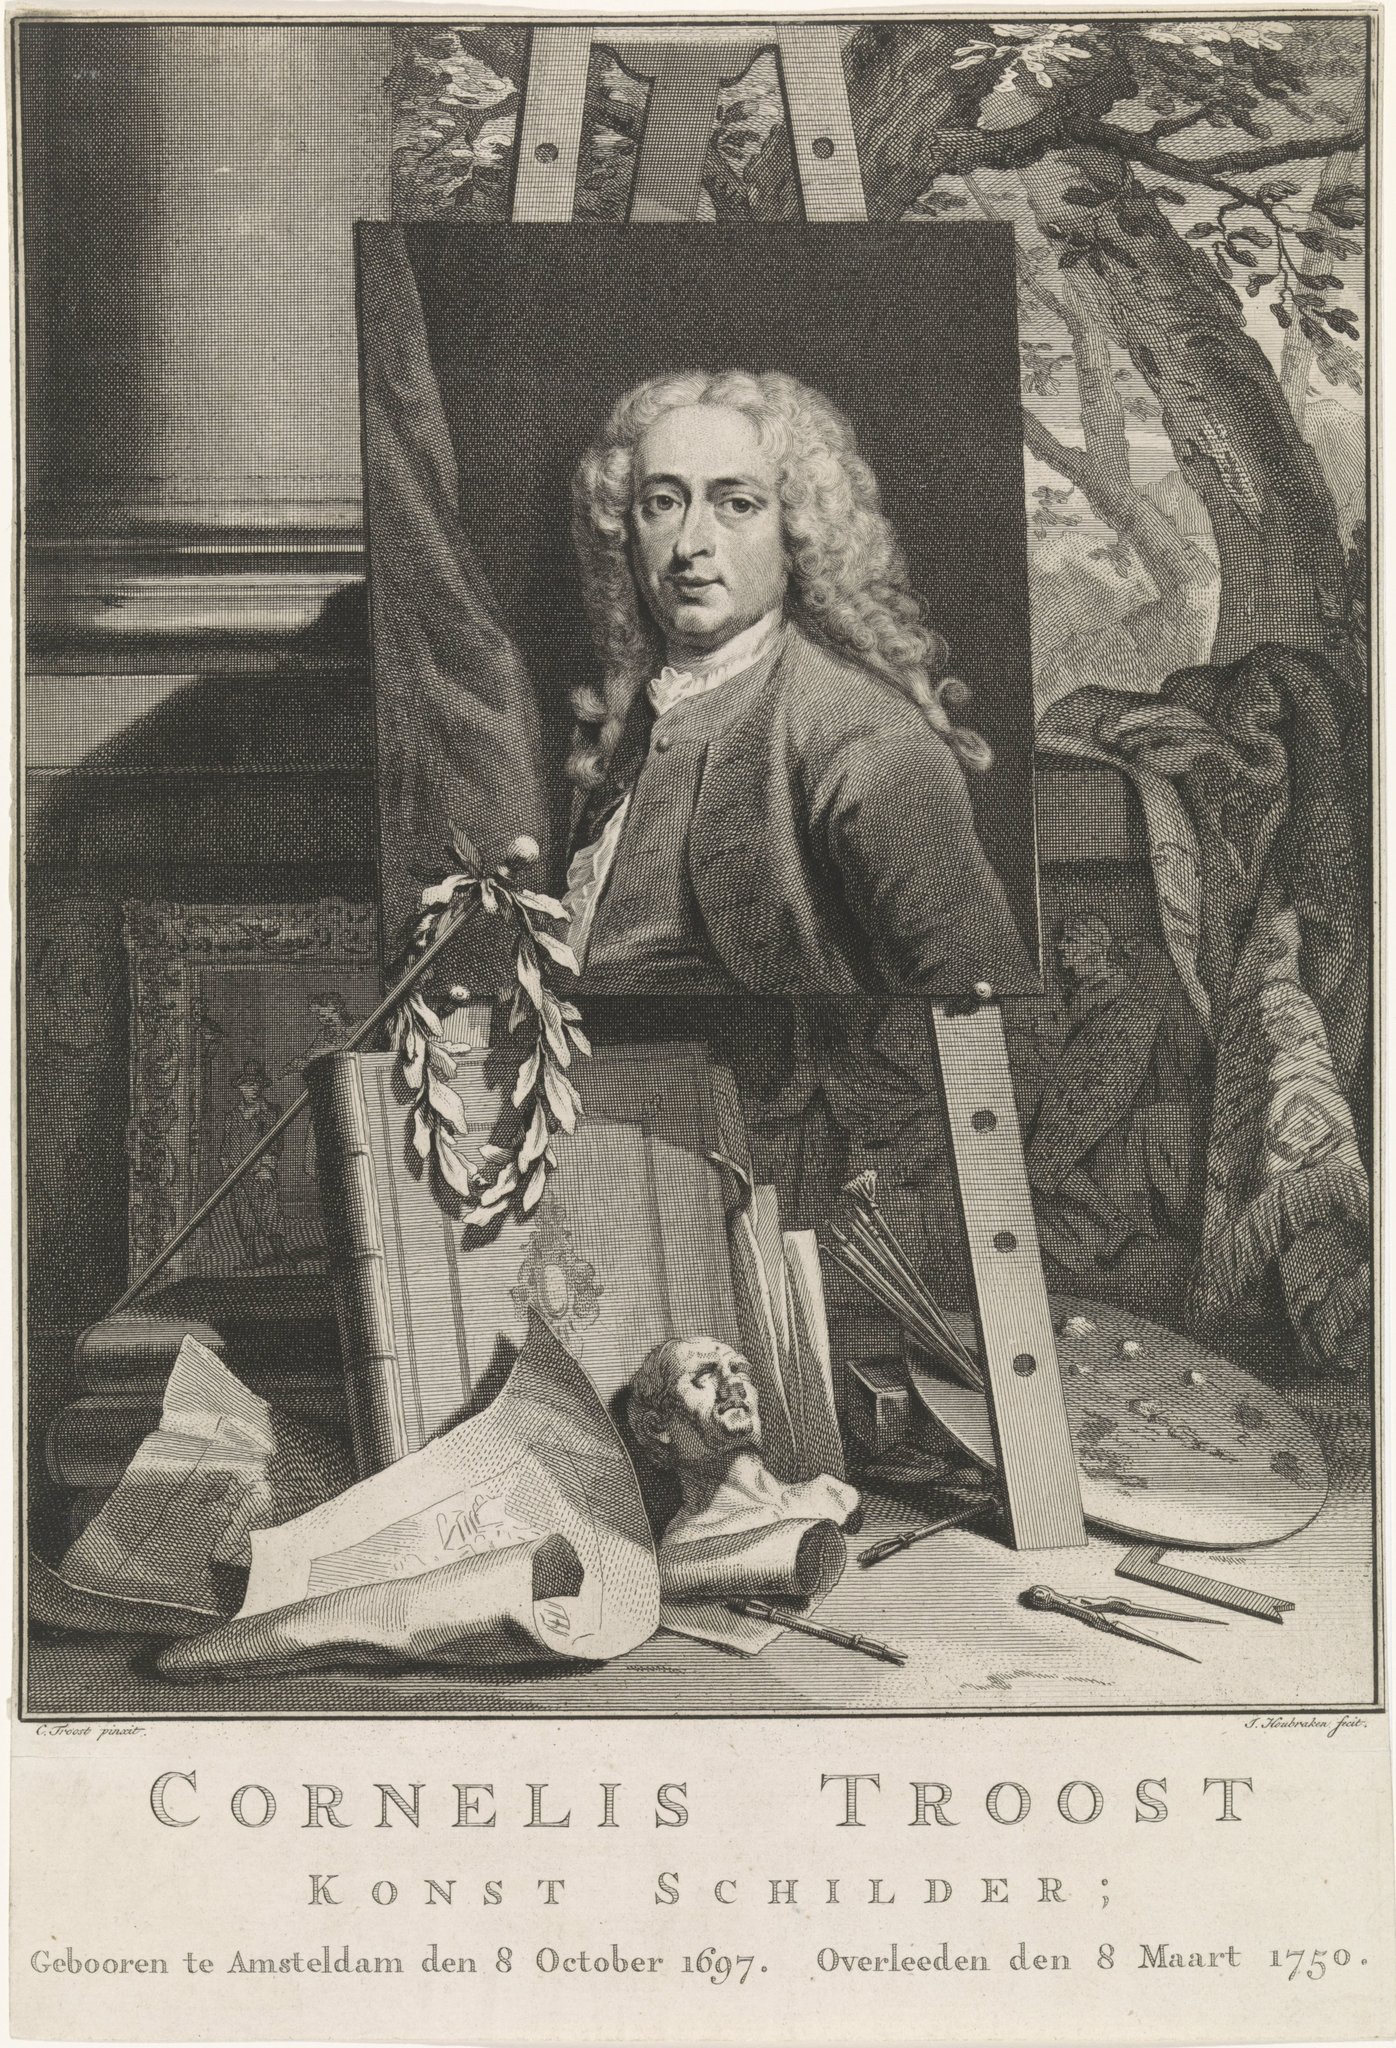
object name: print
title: Portret van Cornelis Troost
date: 1760-1780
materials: paper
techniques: engraving, etching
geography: amsterdam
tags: amsterdam, painter, print maker, draughtsman, cornelis troost, portrait, self-portrait of painter, tools, implements of painter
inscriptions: collector's mark: Lugt 2760, collector's mark: Lugt 2228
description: Portret naar links van de schilder Cornelis Troost. Het schilderij met zijn portret staat op een schildersezel op een bordes en is omringd door de attributen van de schilder- en graveerkunst. Onder de ezel liggen palet en penselen, een gebeeldhouwde kop, tekenstiften, boeken en tekeningen. Links staat de schildersstok, waaraan een lauwerkrans hangt. Daarachter een schilderij in lijst. In de achtergrond een doorkijk naar een landschap. Onder de voorstelling de naam en gegevens van de geportretteerde in drie regels in het Nederlands.